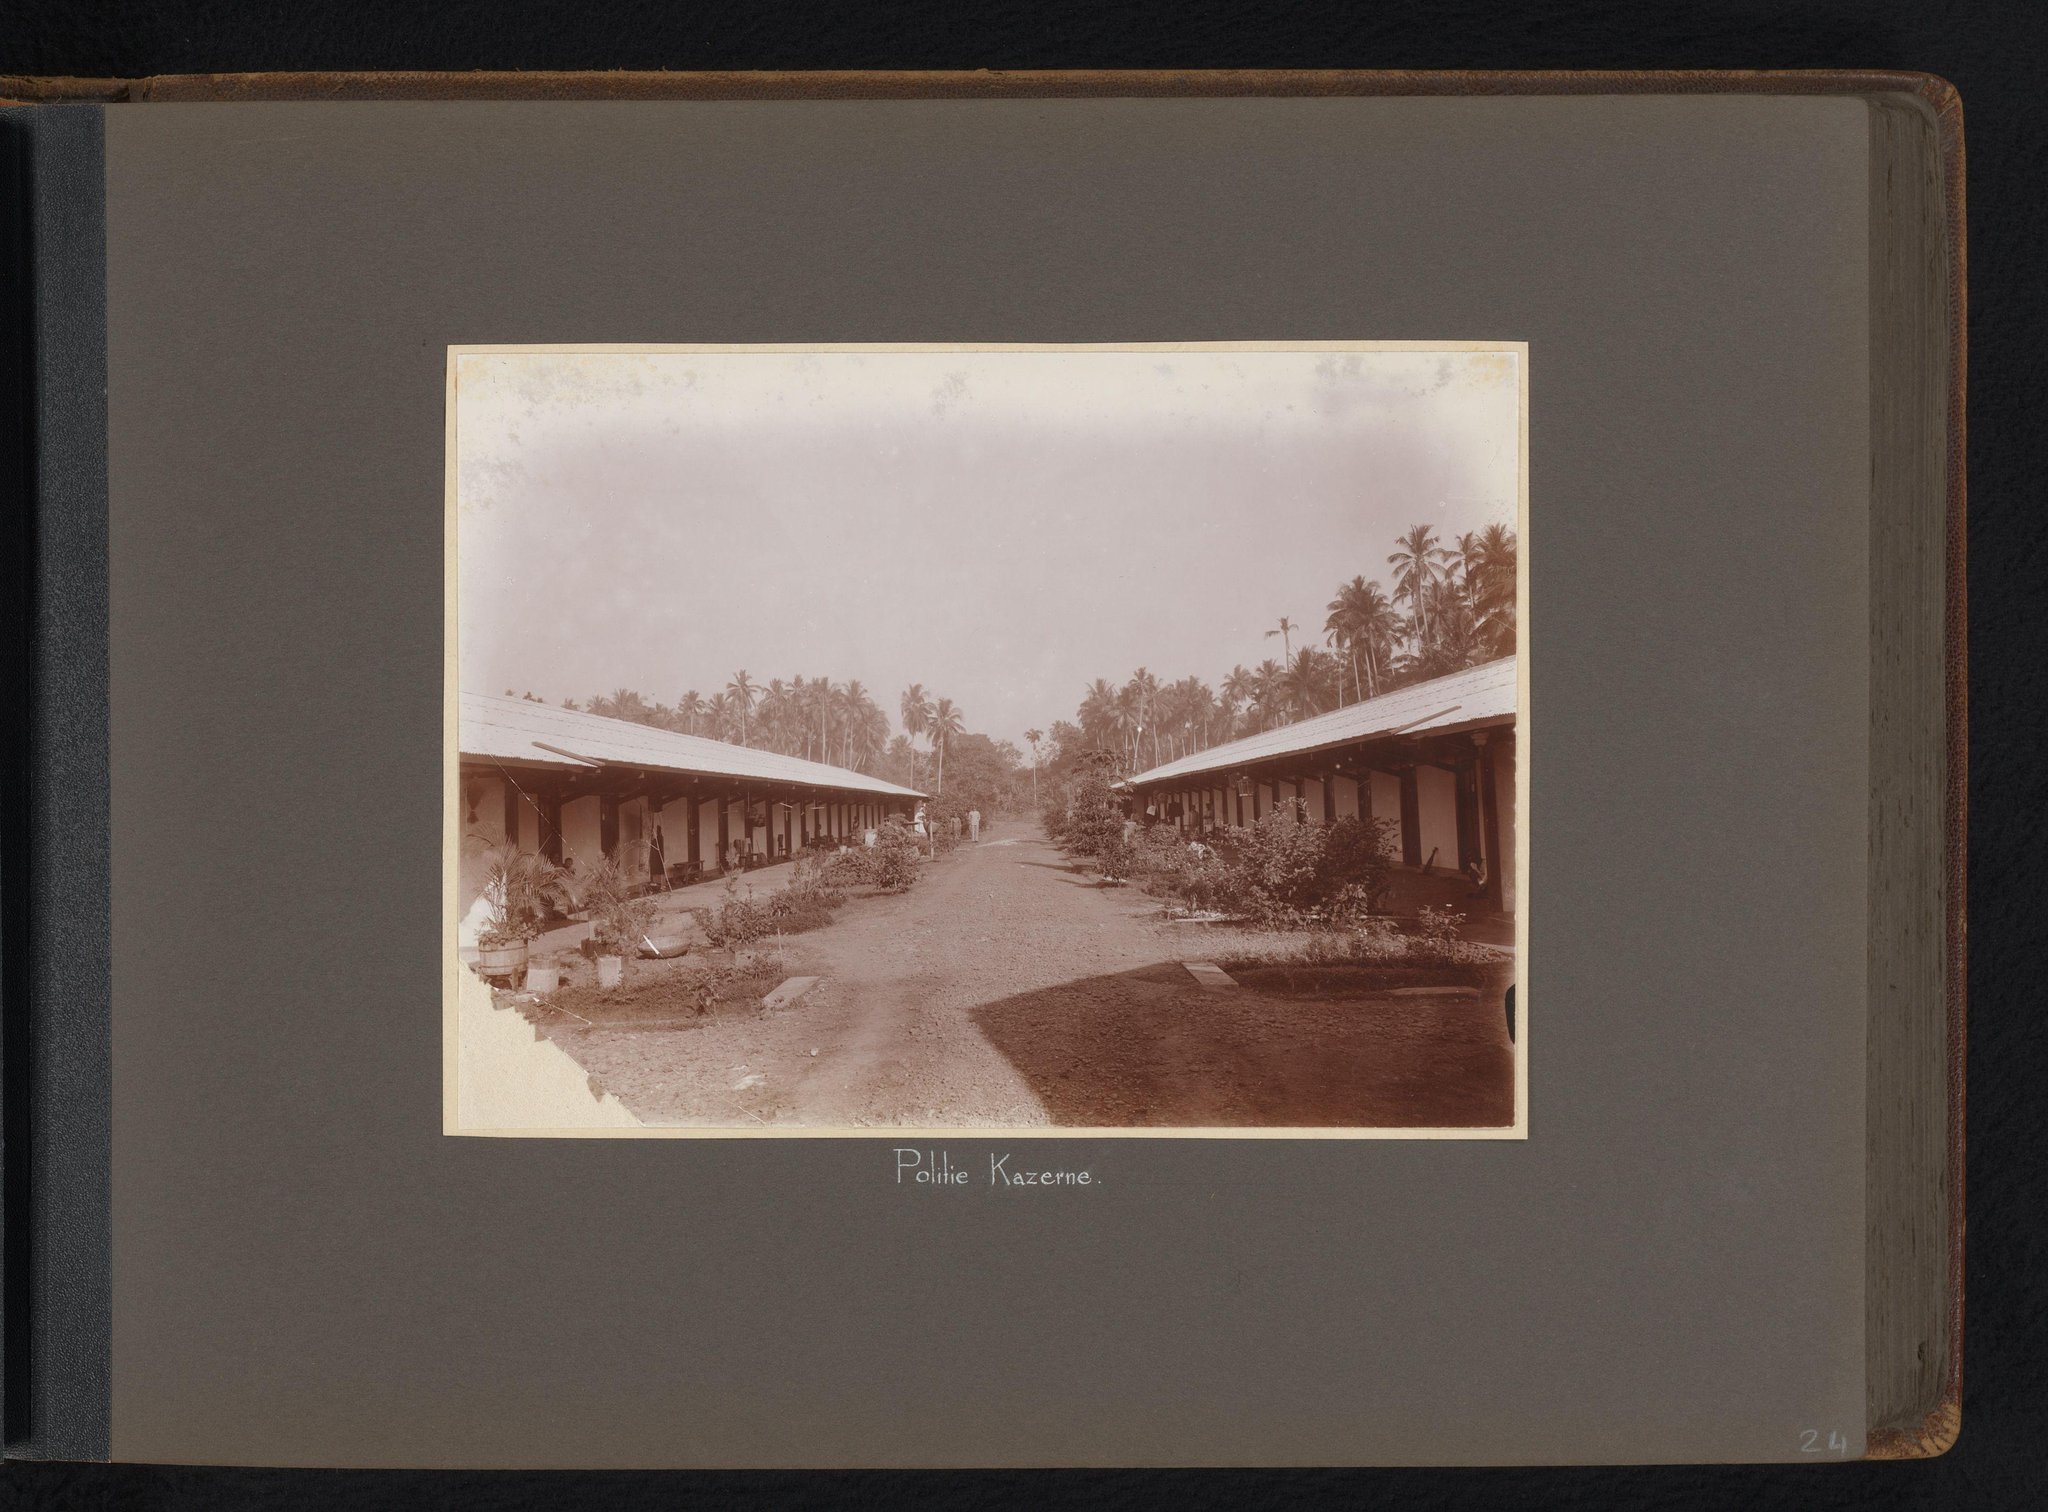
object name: photograph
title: Politie Kazerne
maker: Anonymous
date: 1925-1931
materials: cardboard, photographic support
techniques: collodion silver print, gelatin silver print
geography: batavia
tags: dutch east indies, the, batavia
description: Albumblad met één foto: een politiekazerne te Batavia. Onderdeel van het fotoalbum aangeboden aan S. Koster door de Vereeniging van Hoogere Politie Ambtenaren in Nederlandsch-Indië in 1931.